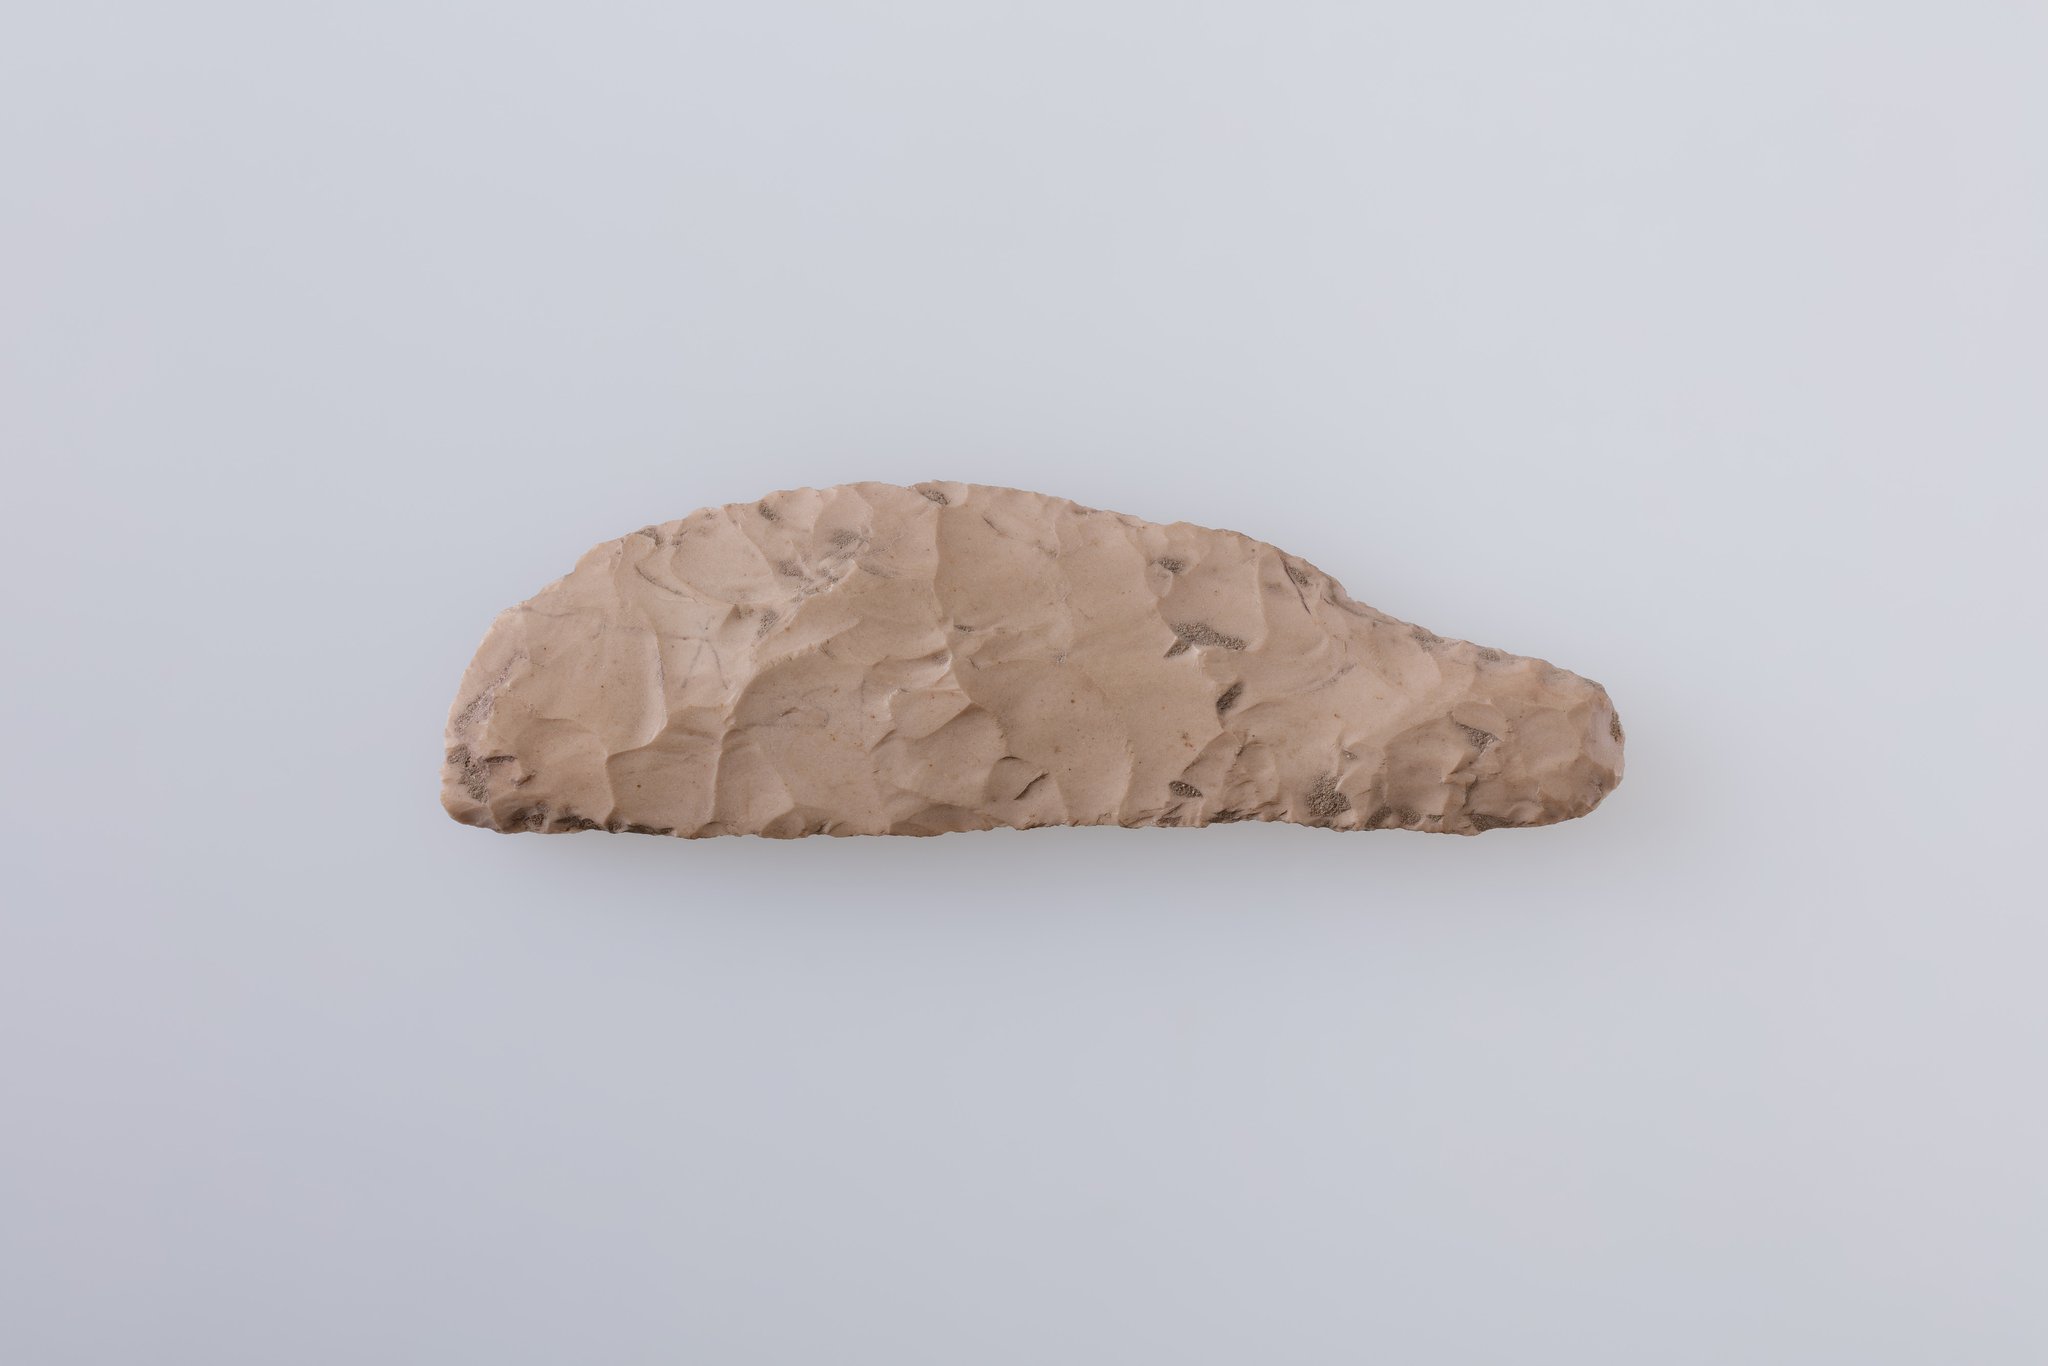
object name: knife, bifacial knife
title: Bifacial knife with handle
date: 3100-2649 BCE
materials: stone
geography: egypt